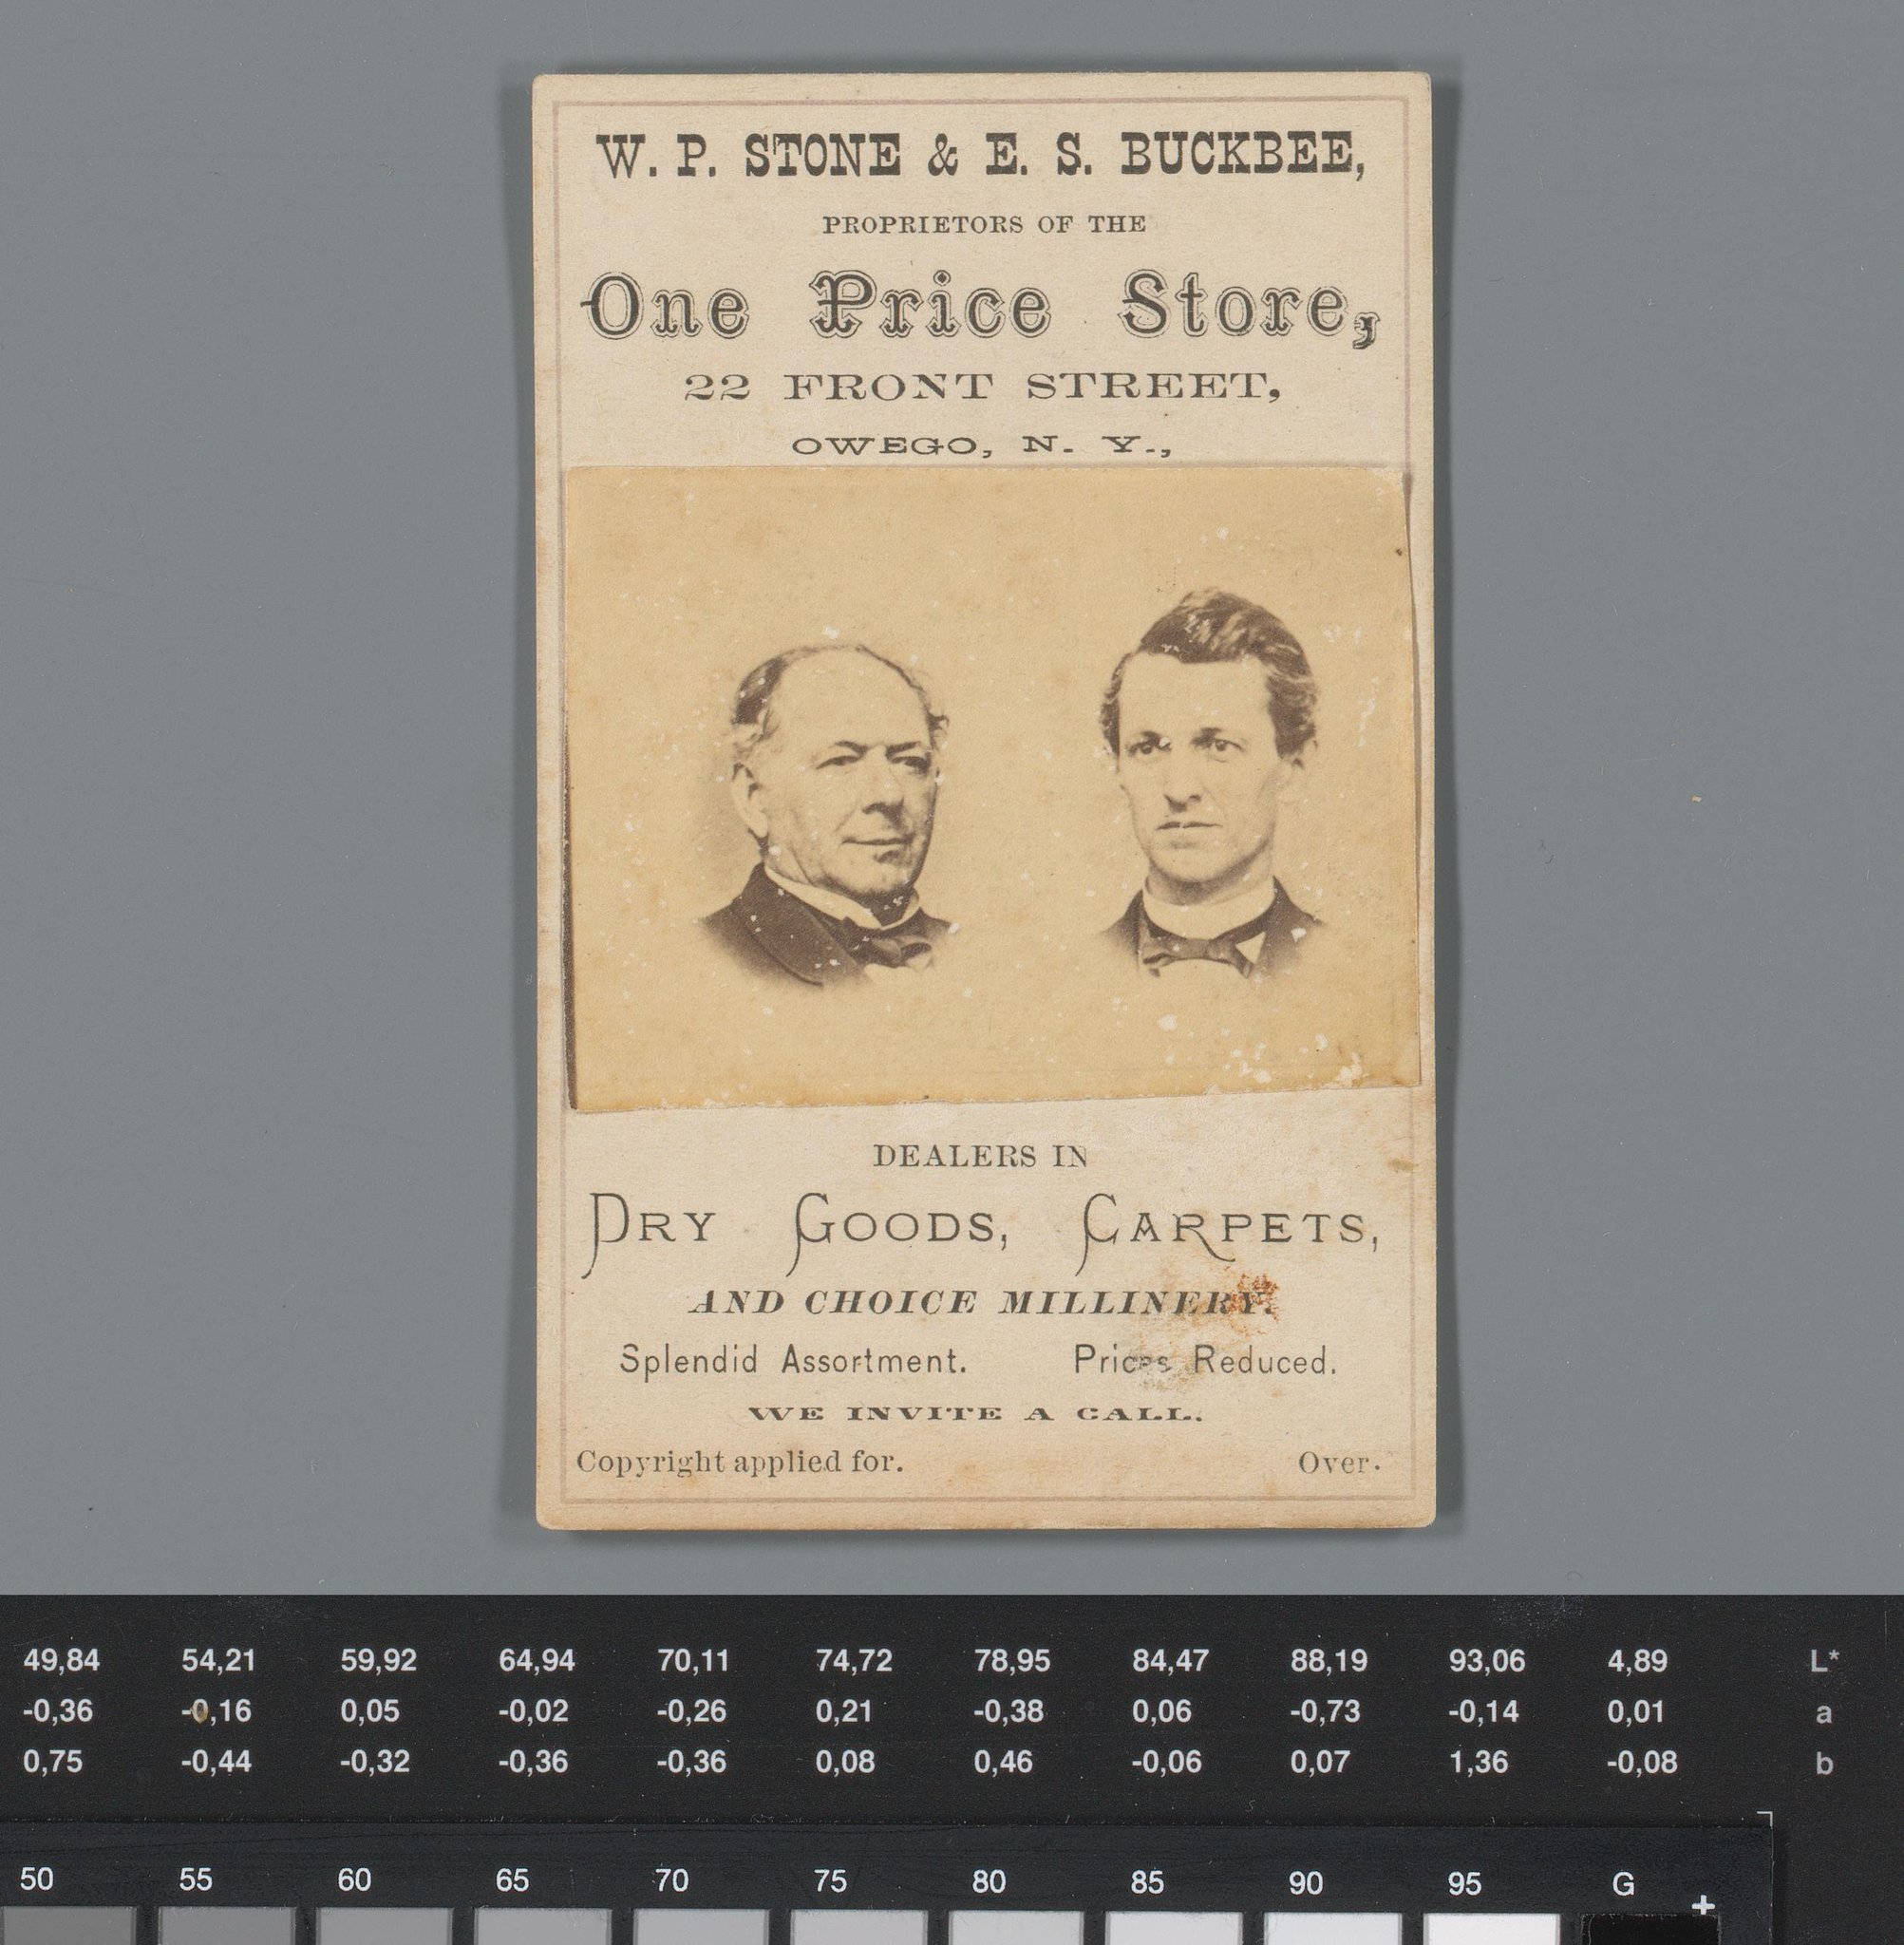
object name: carte de visite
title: Reclame voor textielwaren van W.P. Stone en E.S. Buckbee te Owego met portret twee onbekende mannen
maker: Anonymous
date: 1850-1915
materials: cardboard, photographic support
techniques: albumen print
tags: advertising, historical persons not known by name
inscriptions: inscription: ‘W.P. STONE & E.S. BUCKBEE, / PROPRIETORS OF THE / One Price Store, / Owego, N.Y., / DEALERS IN / DRY GOODS, CARPETS, / AND CHOICE MILLINERY (...)’, inscription: ‘"Economy is Wealth!" (...) BEST GOODS / AT / LOWEST PRICES.(...)’